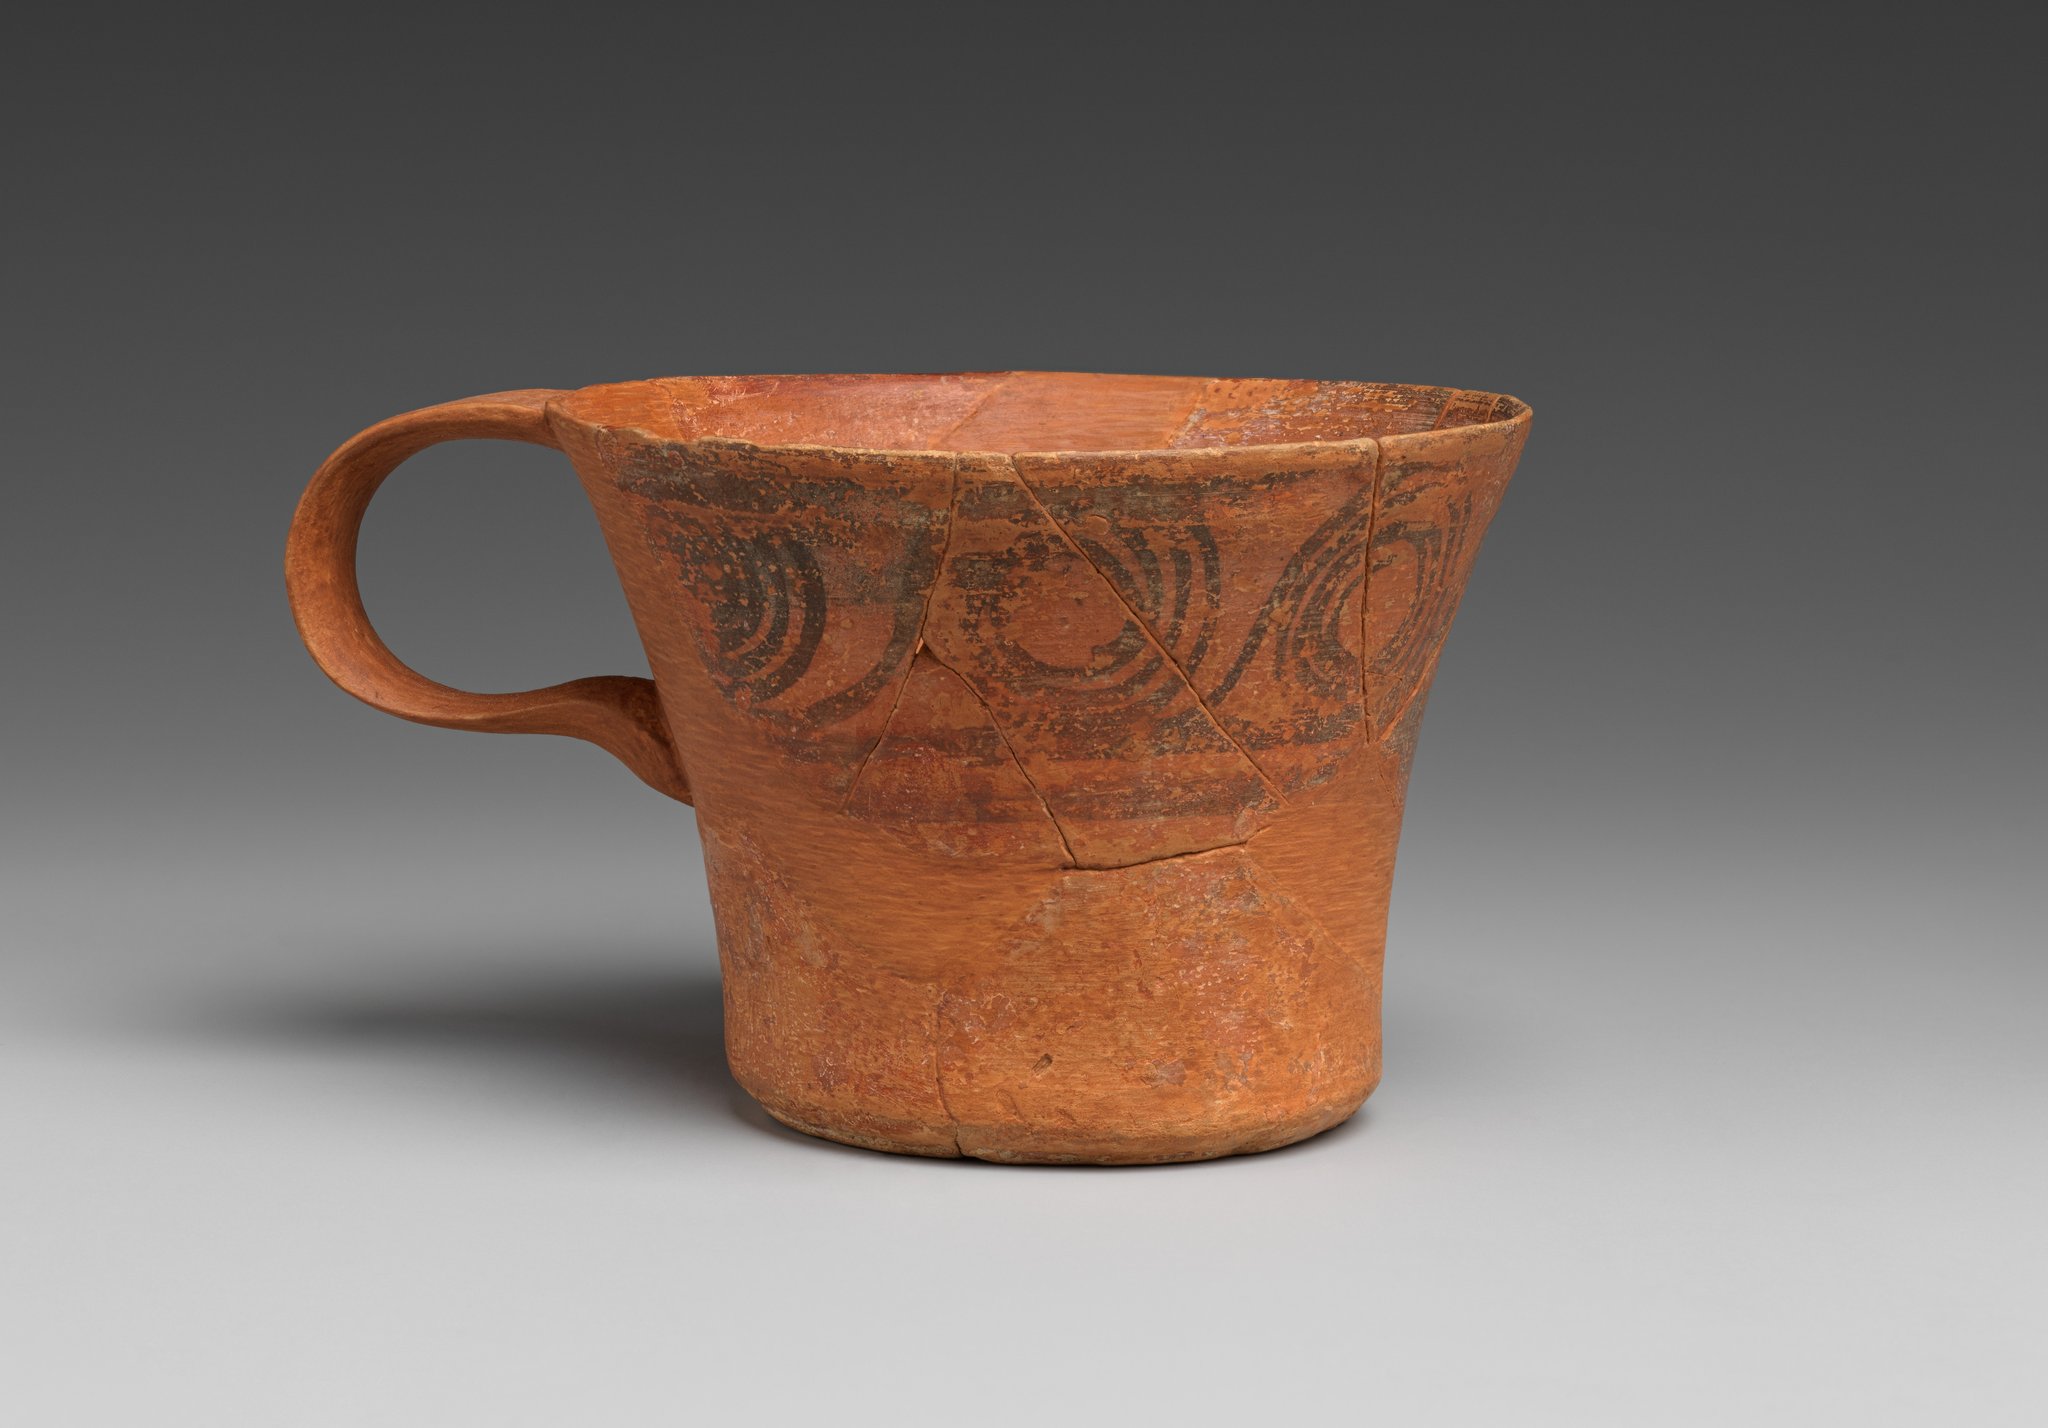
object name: cup, one handled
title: Terracotta one-handled cup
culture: minoan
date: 1600-1500 BCE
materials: terracotta